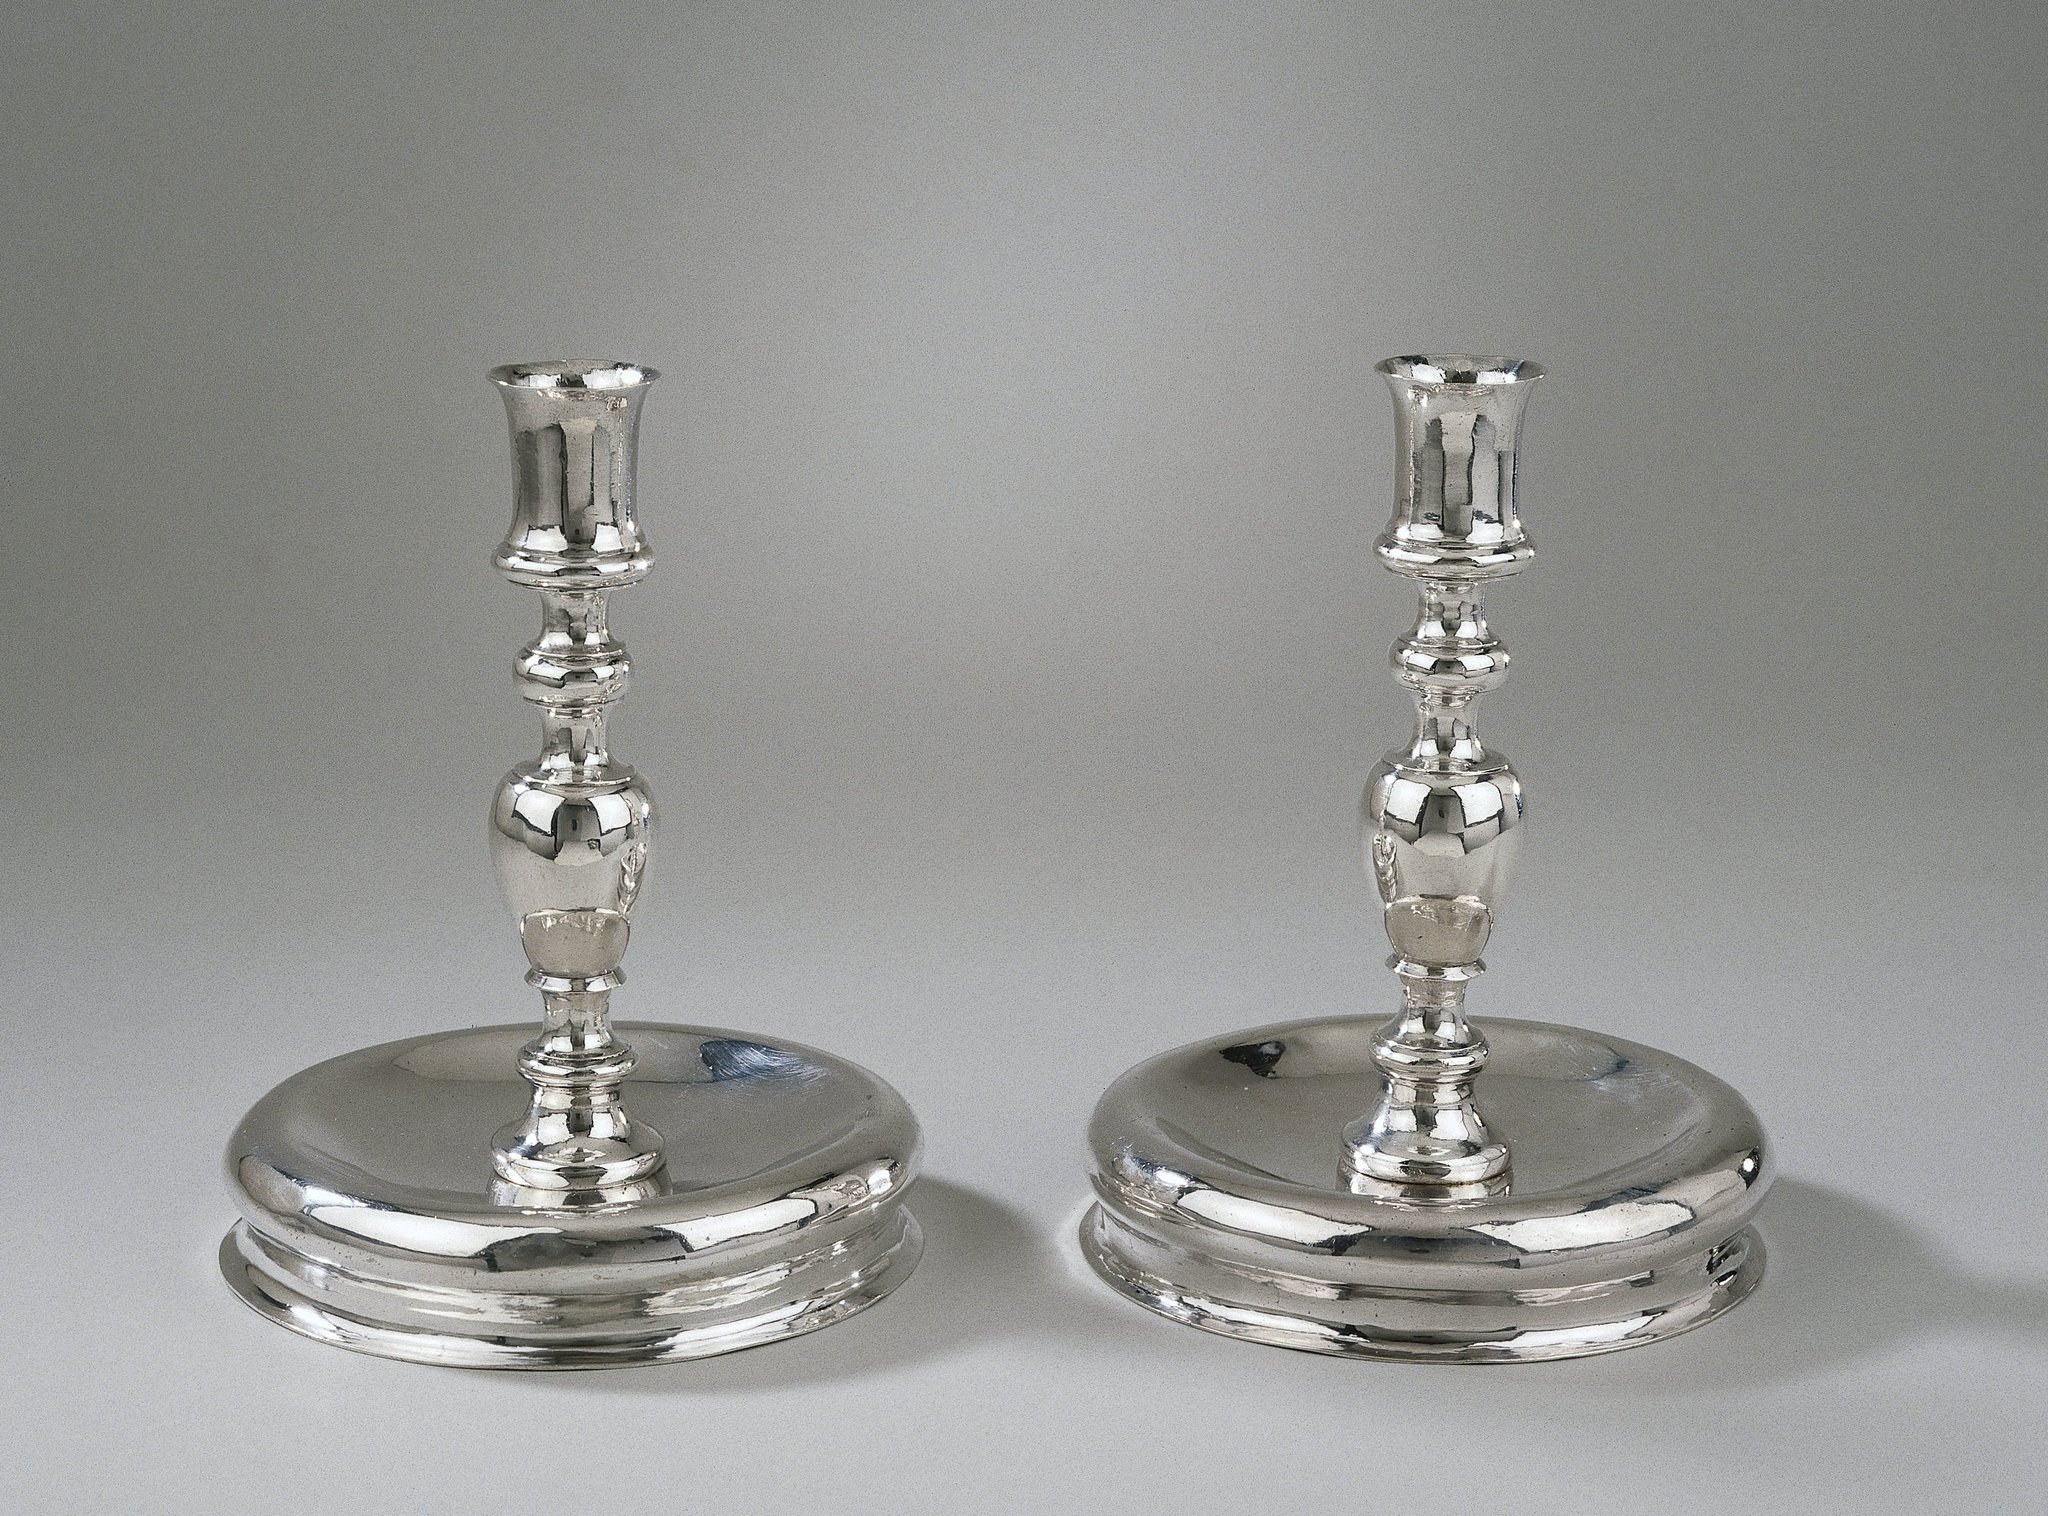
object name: candlestick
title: Kandelaar met balusterstam en ronde, komvormige voet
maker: jacob feeterse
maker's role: silversmith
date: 1900-1923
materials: silver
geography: amsterdam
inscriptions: town mark (false), (false): ‘L’, maker's mark (false), date letter (false): ‘V’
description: De ronde kandelaars hebben een gewelfde voet met een verdiepte bovenzijde, waarin een vierkante moer is verzonken. Hierin is de stam vastgeschroefd. De stam is opgebouwd uit een baluster gevat tussen diabolo- en gedrukt bolvormige elementen. De kaarsenhouder is diabolo-vormig.